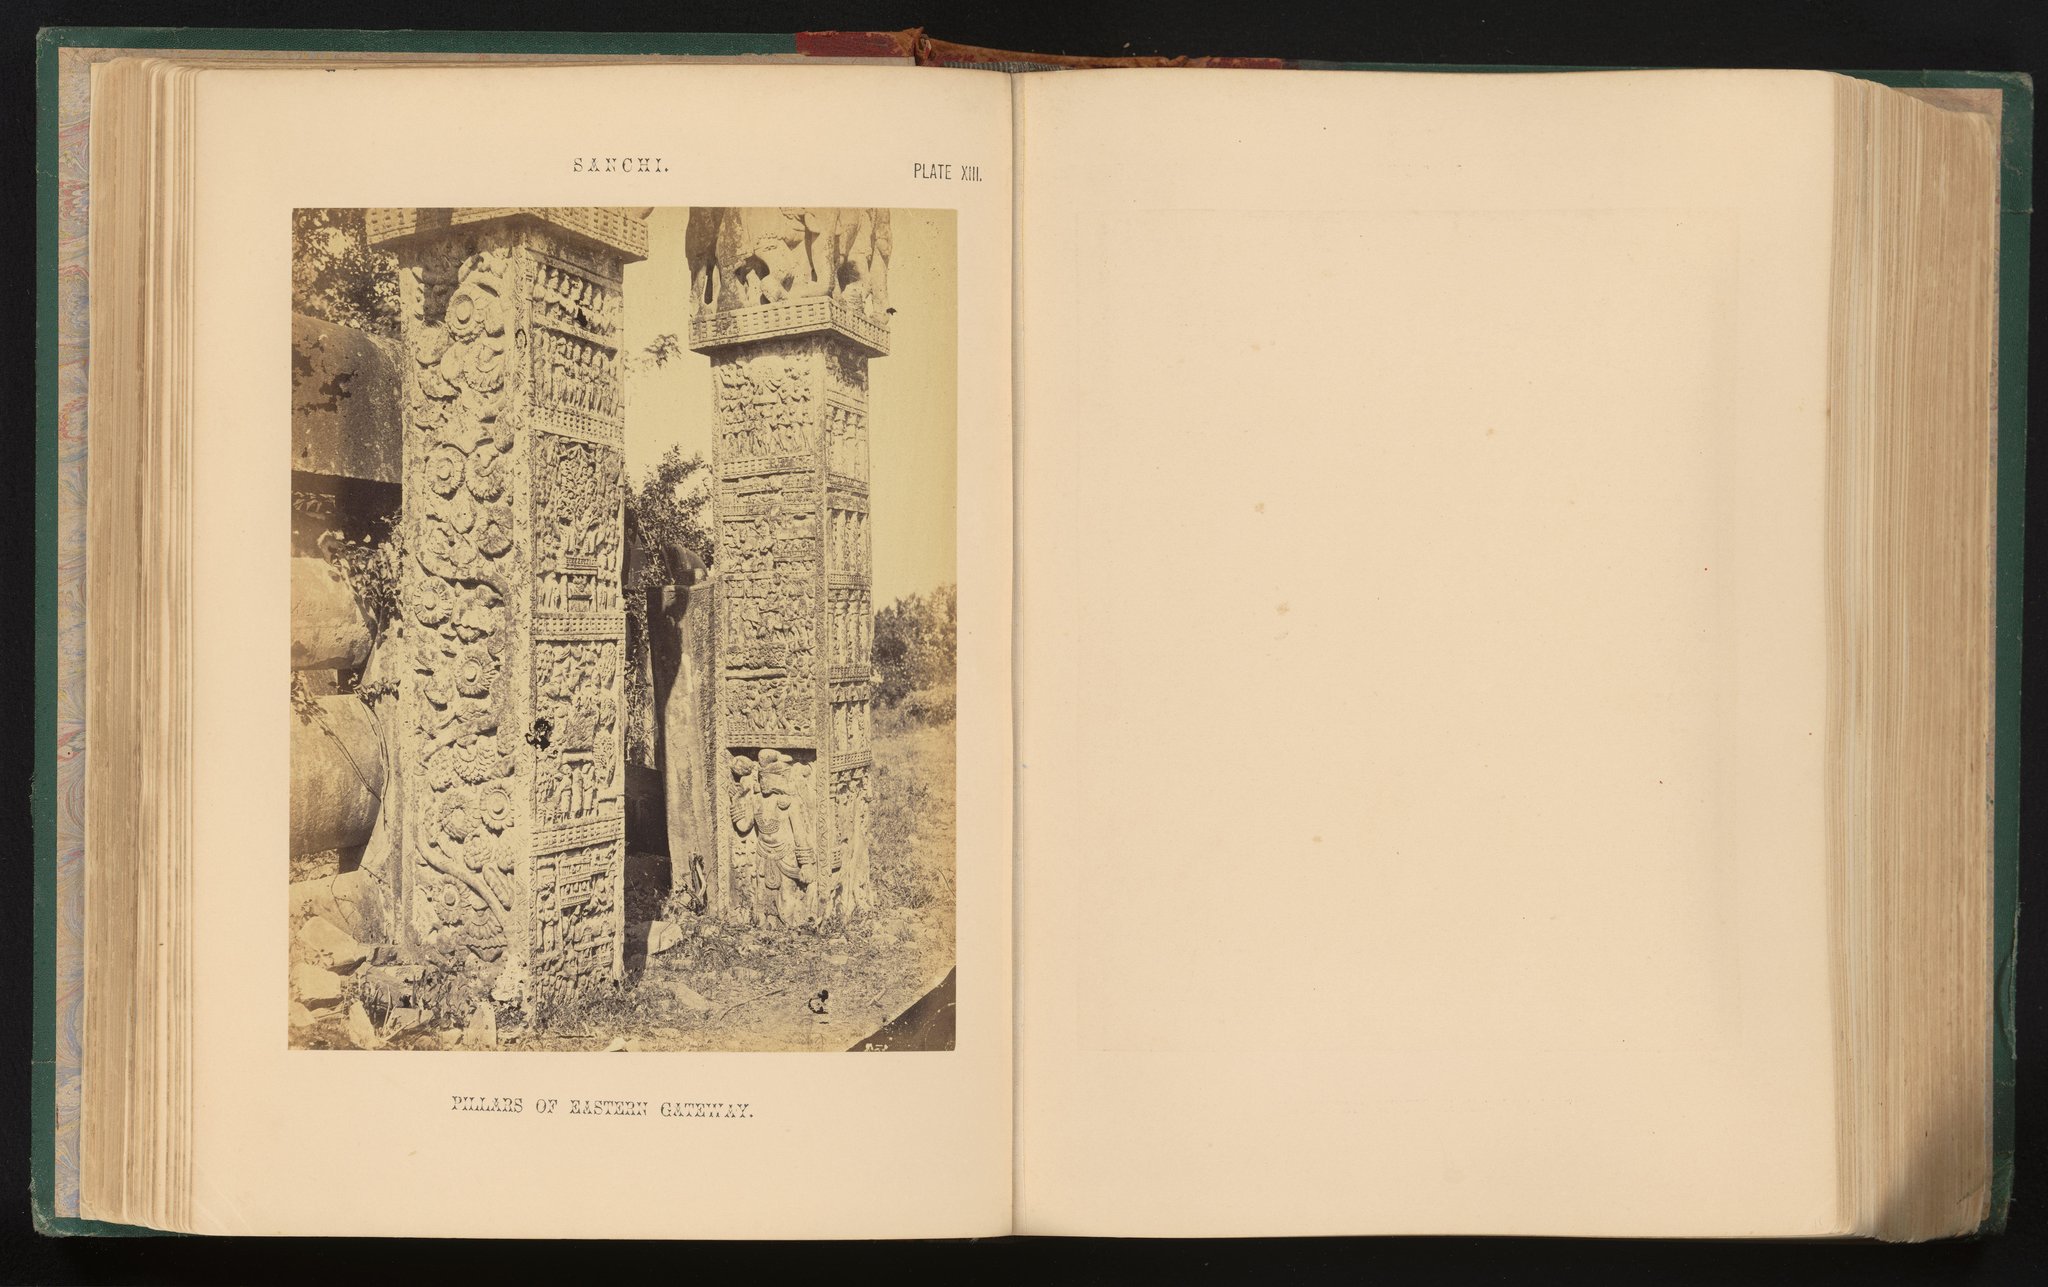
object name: page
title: Pillars of the eastern gateway (torana) of the Great Stupa at Sanchi, Madhya Pradesh, India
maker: james john waterhouse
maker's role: fotograaf, luitenant, officier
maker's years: 1842-1928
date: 1863-1868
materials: photographic support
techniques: albumen print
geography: sanchi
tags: column, pillar ~ architecture, places and objects of worship ~ hinduism, buddhism, jainism, gate, entrance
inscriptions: inscription: ‘SANCHI. PLATE XIII./ PILLARS OF EASTERN GATEWAY.’